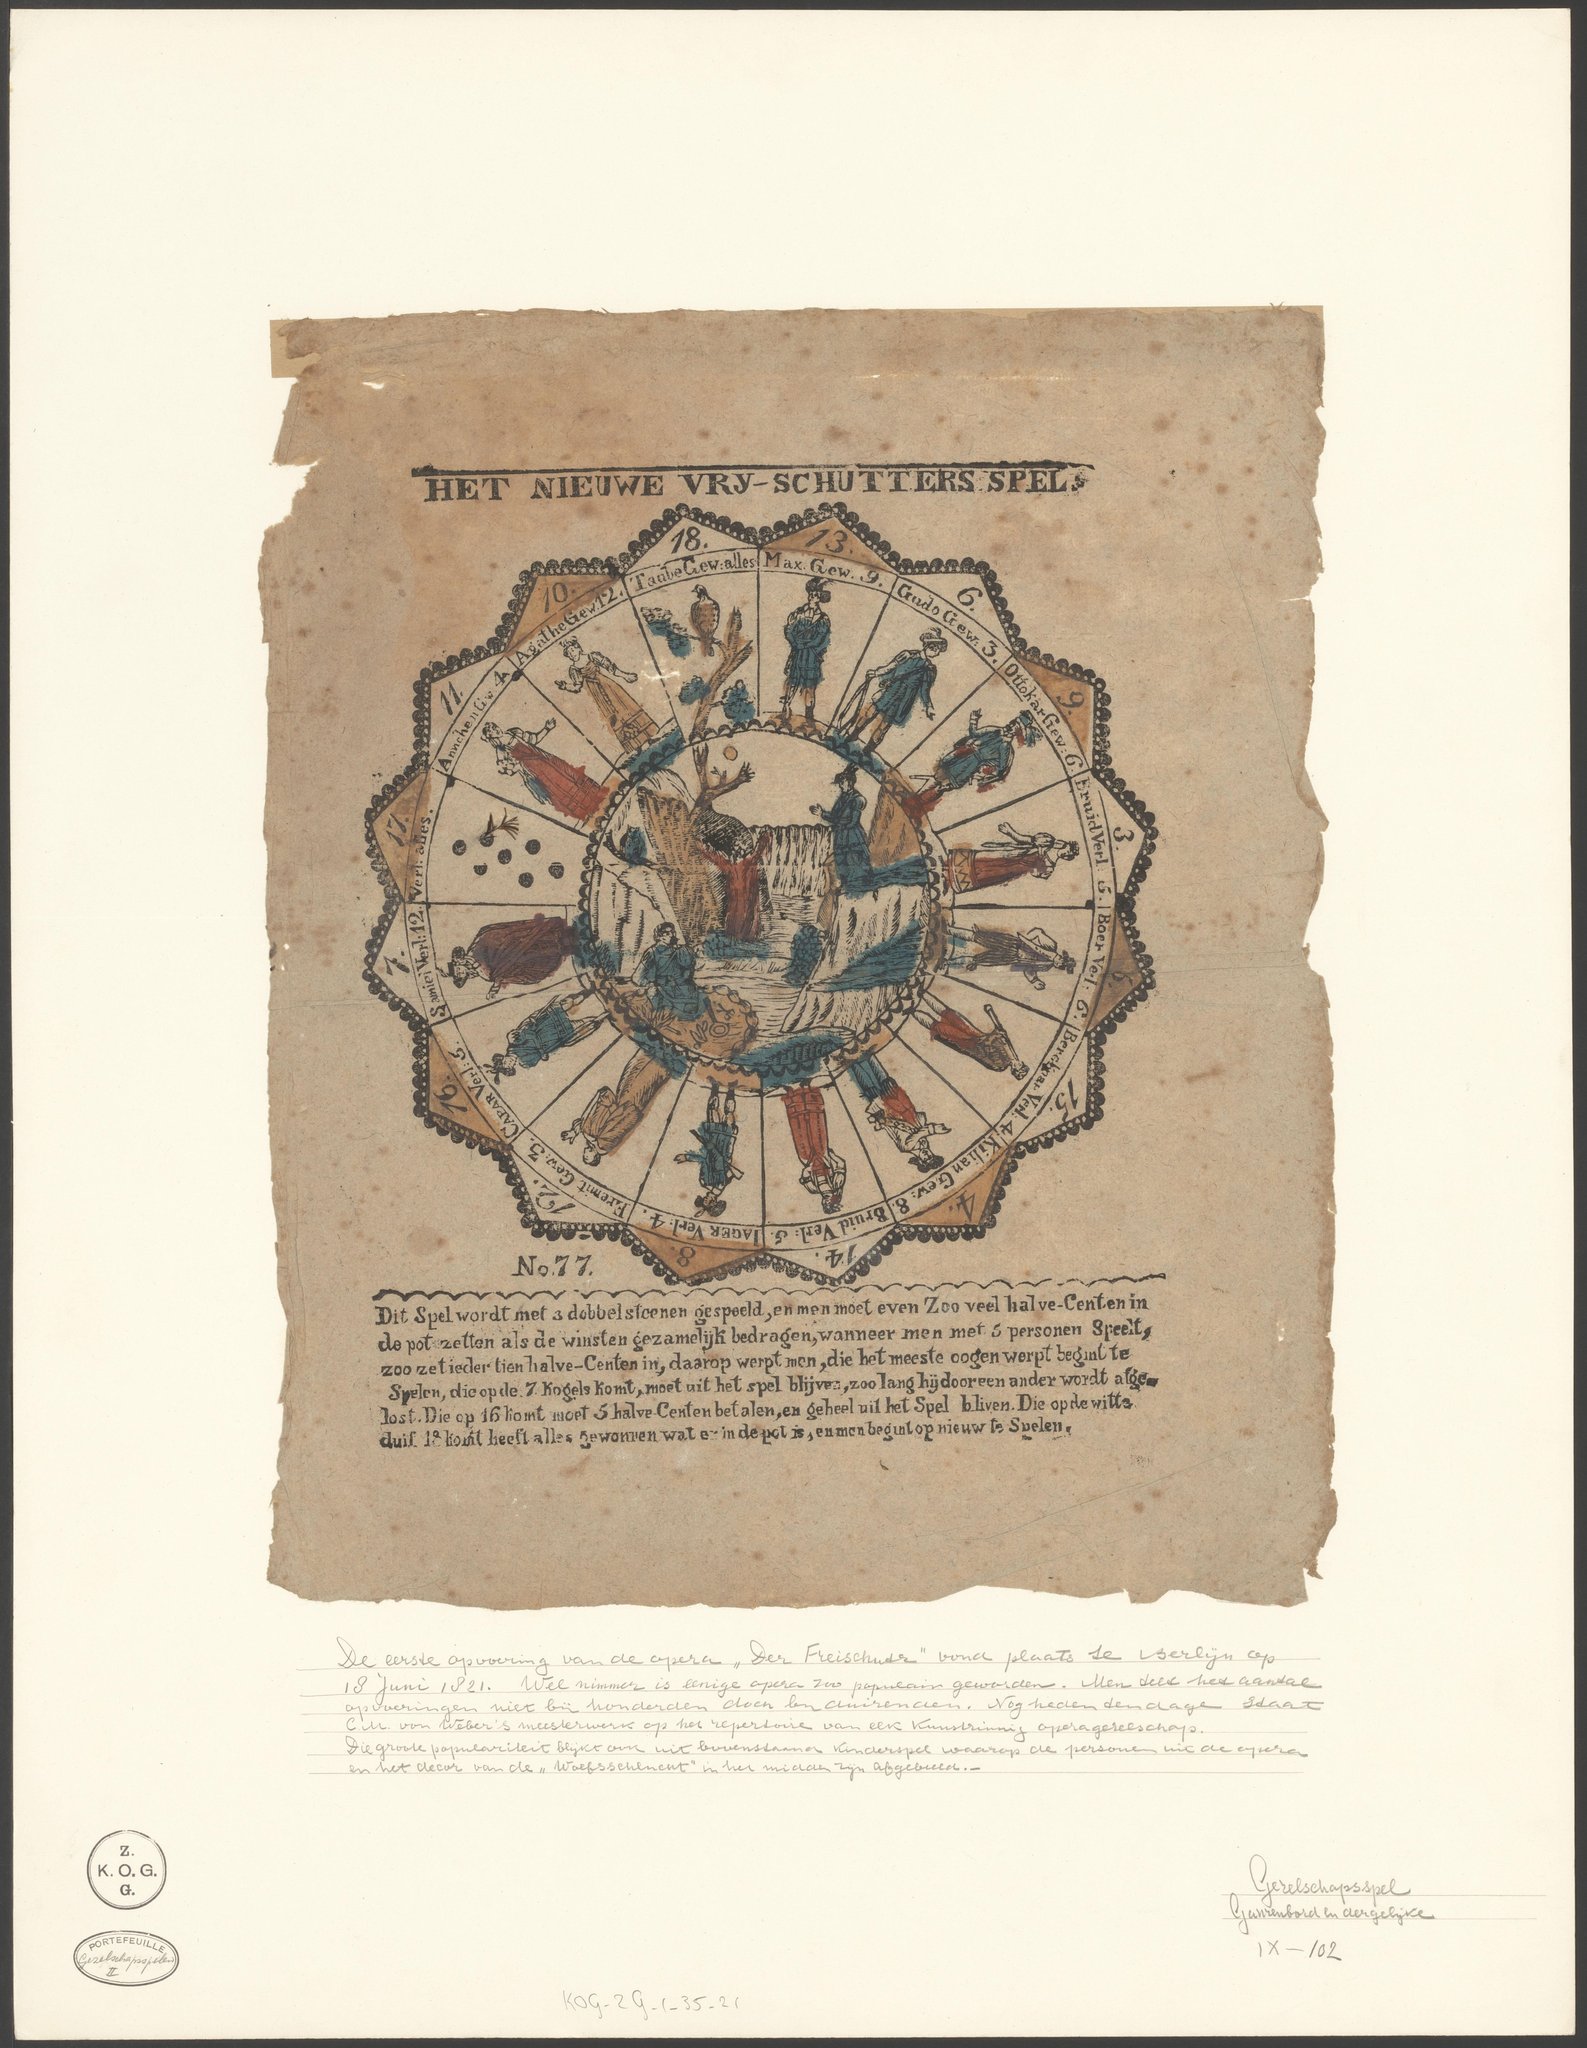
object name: print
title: Speelbord van het nieuwe vrij schuttersspel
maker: Anonymous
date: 1800-1825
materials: paper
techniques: hand coloring, lithograph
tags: board-games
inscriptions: stamp, collector's mark: Lugt 1641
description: Een werpspel met in een cirkel 16 vakken waarvan 14 met afbeeldingen van personages uit de opera: "der Freischütz""van Von Weber, één vak met zeven kogels en één met een duif. In het midden een afbeelding van de "Wolfsschlucht'. Onder het spel de spelregels. Linksonder het spel: No. 77. Onderwerpsrubrieken binnen de Atlas Zeden en Gewoonten: Zeden en gewoonten in engeren zin, Spel en vermaak, Gezelschapsspel II, Ganzenbord en dergelijke.